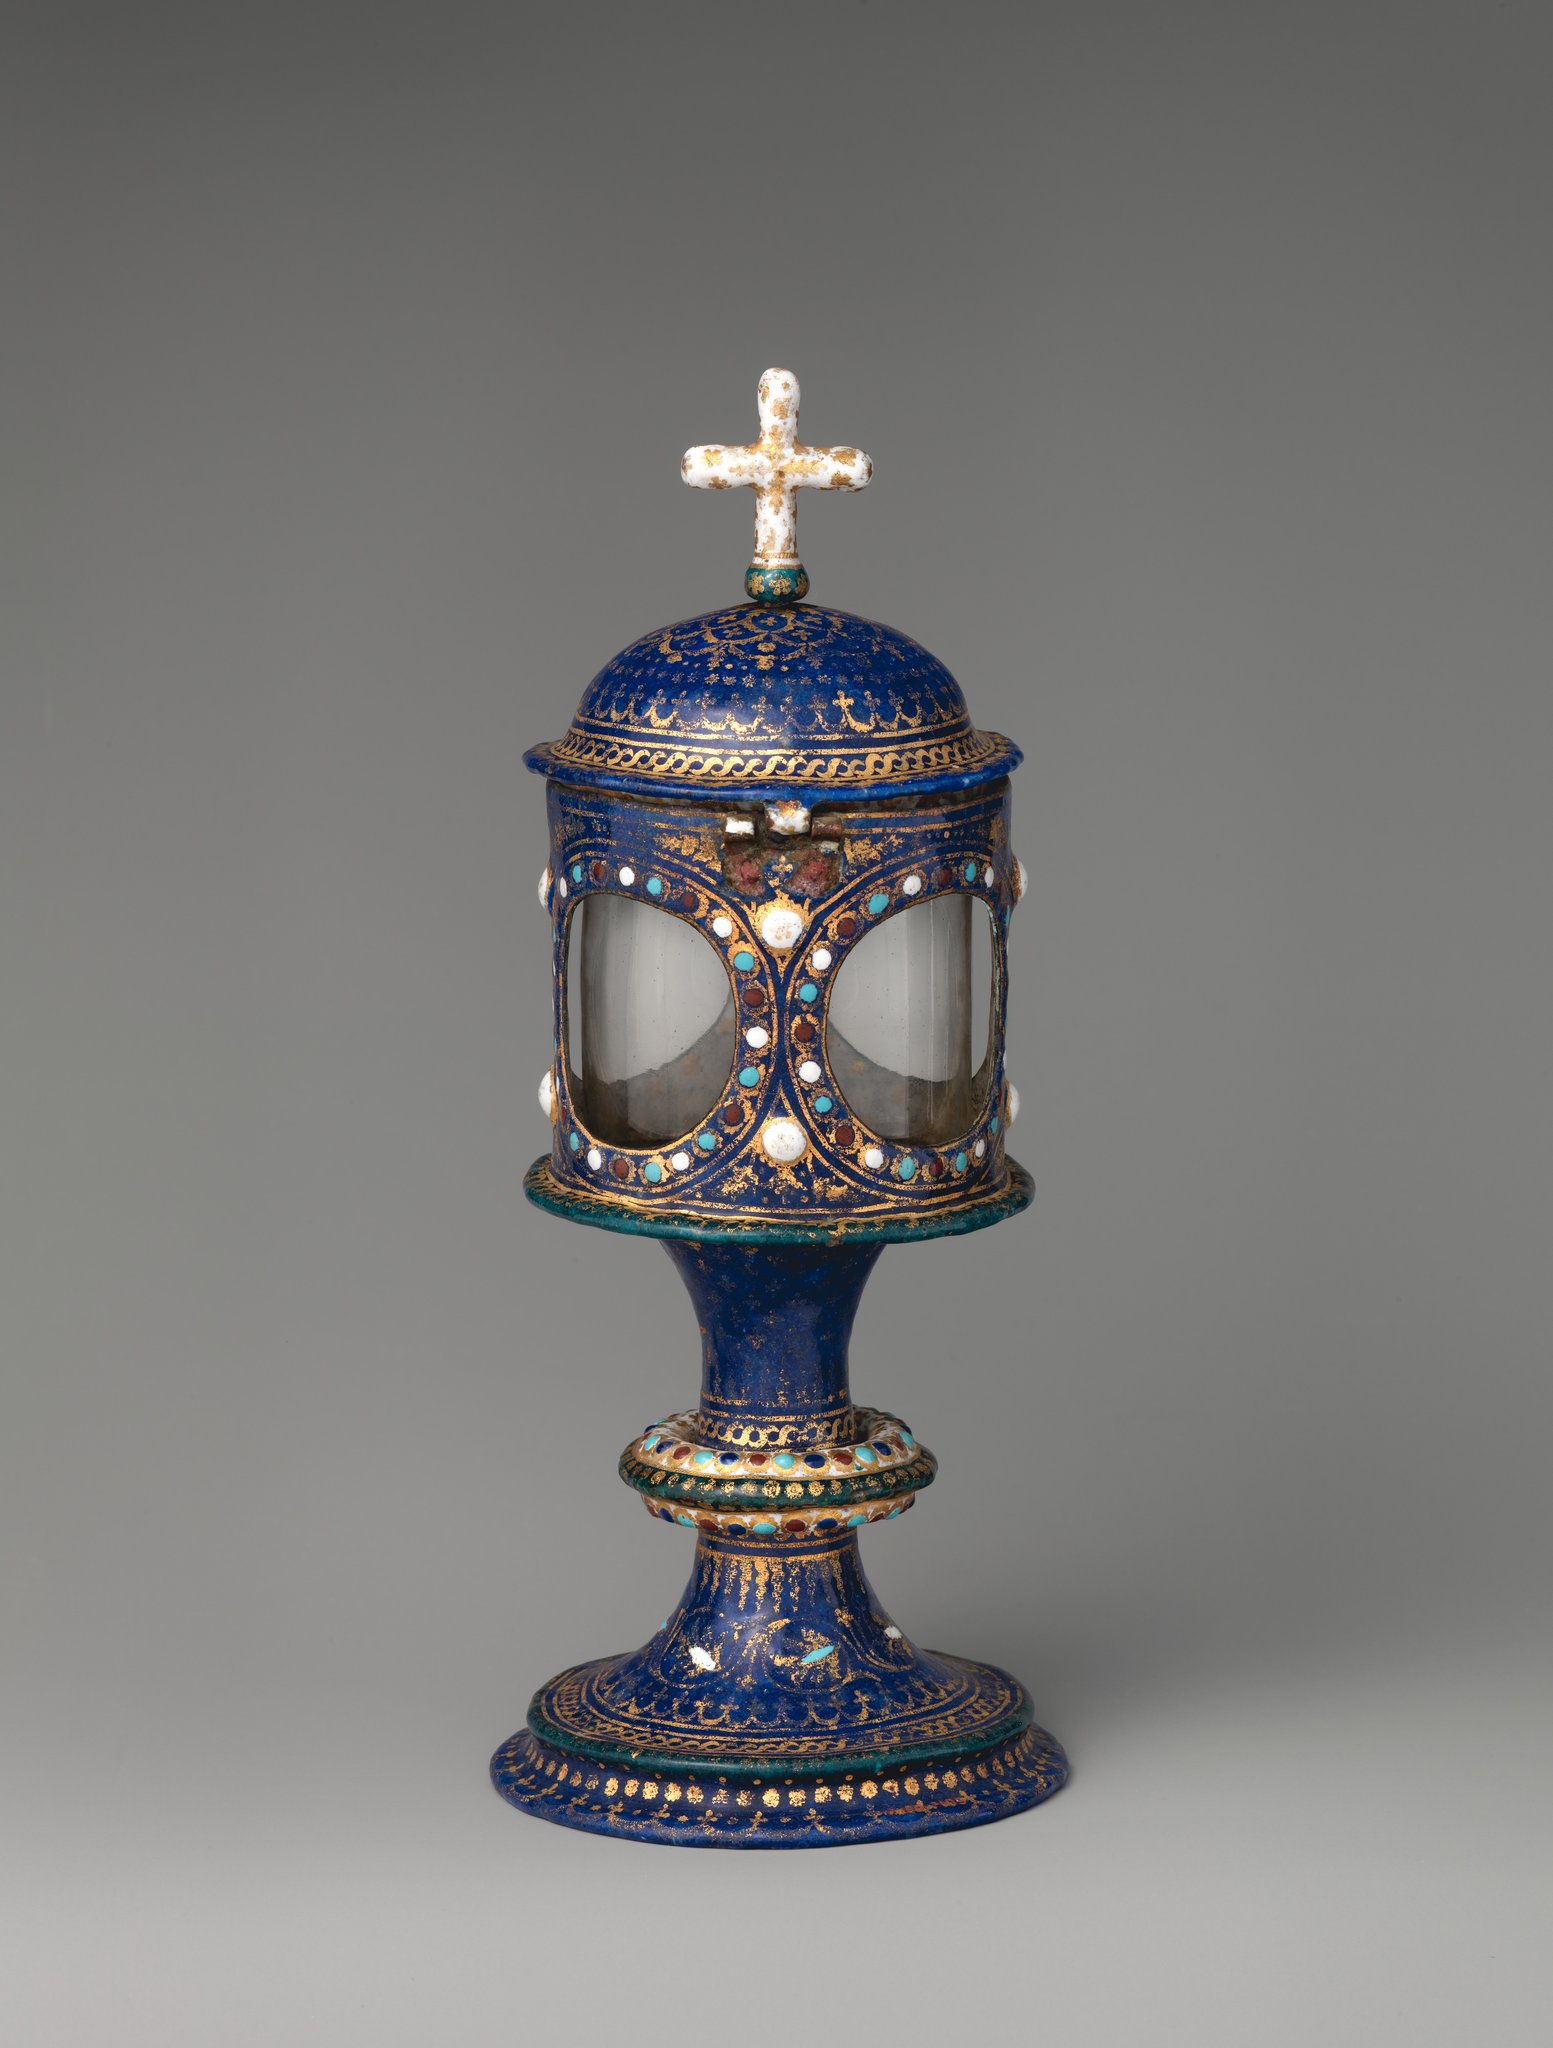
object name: reliquary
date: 1467-1533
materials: copper, enamel, gilt, glass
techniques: painting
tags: cross,reliquaries